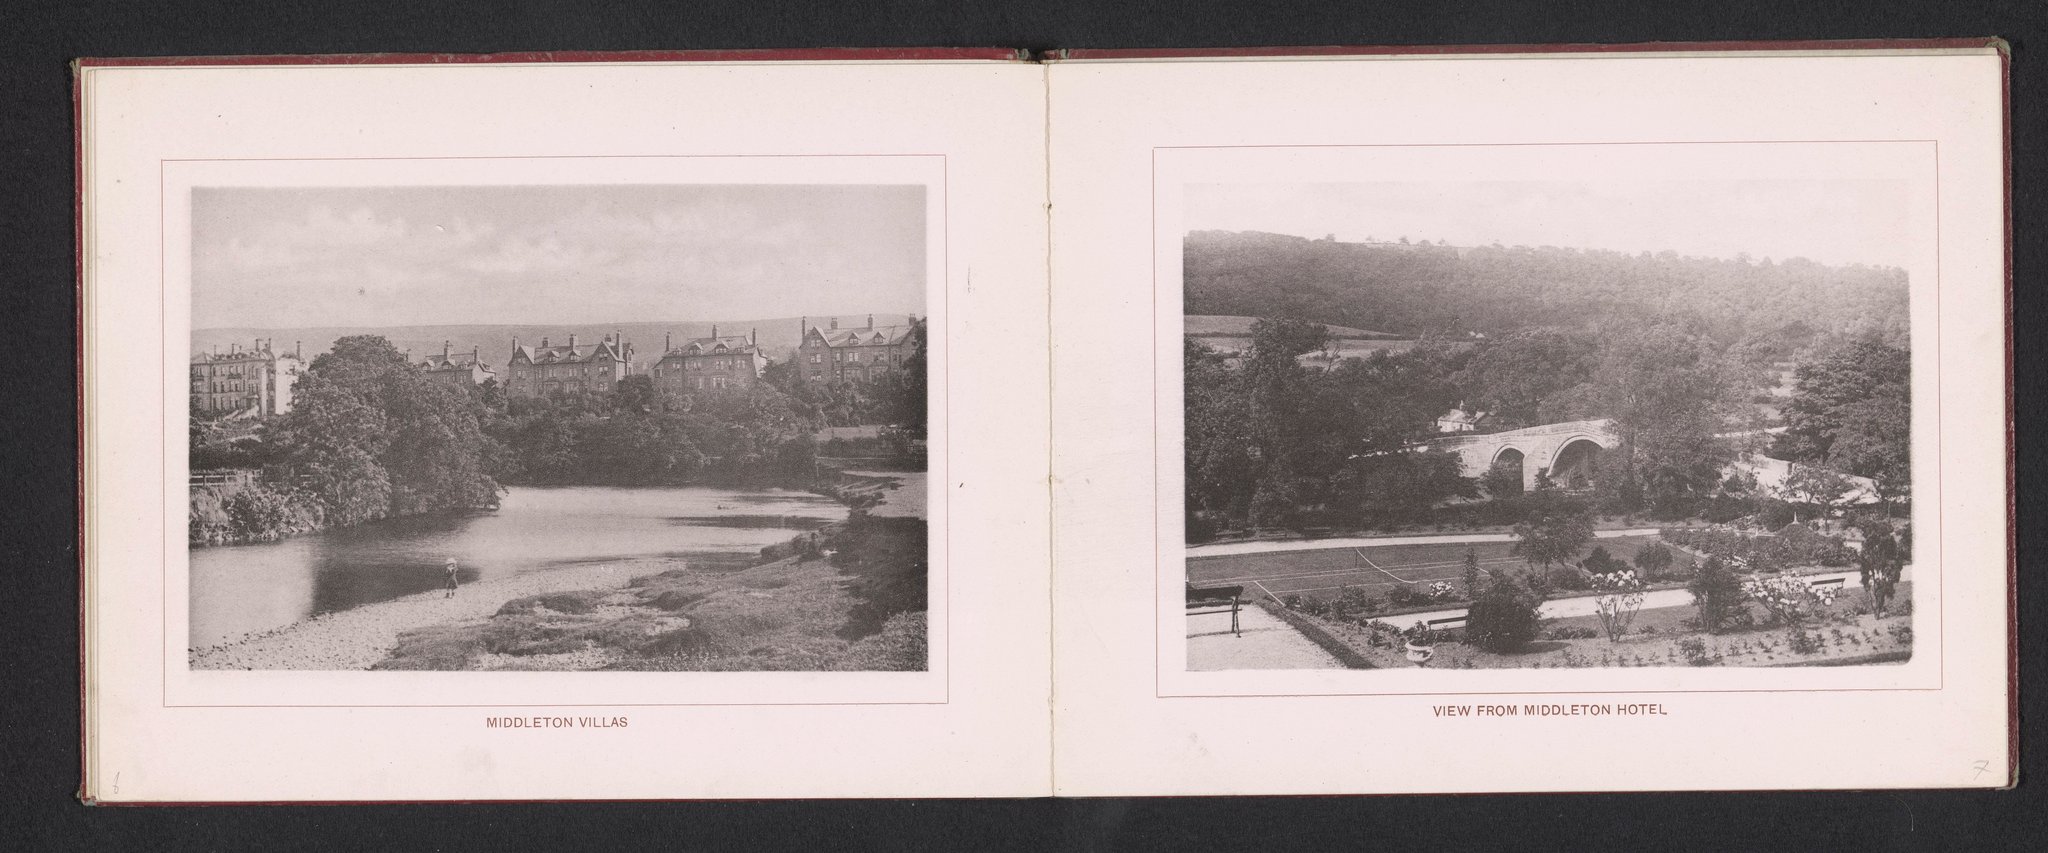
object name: page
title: View from Middleton hotel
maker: Anonymous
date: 1890-1900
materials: paper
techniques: photograph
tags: bridge